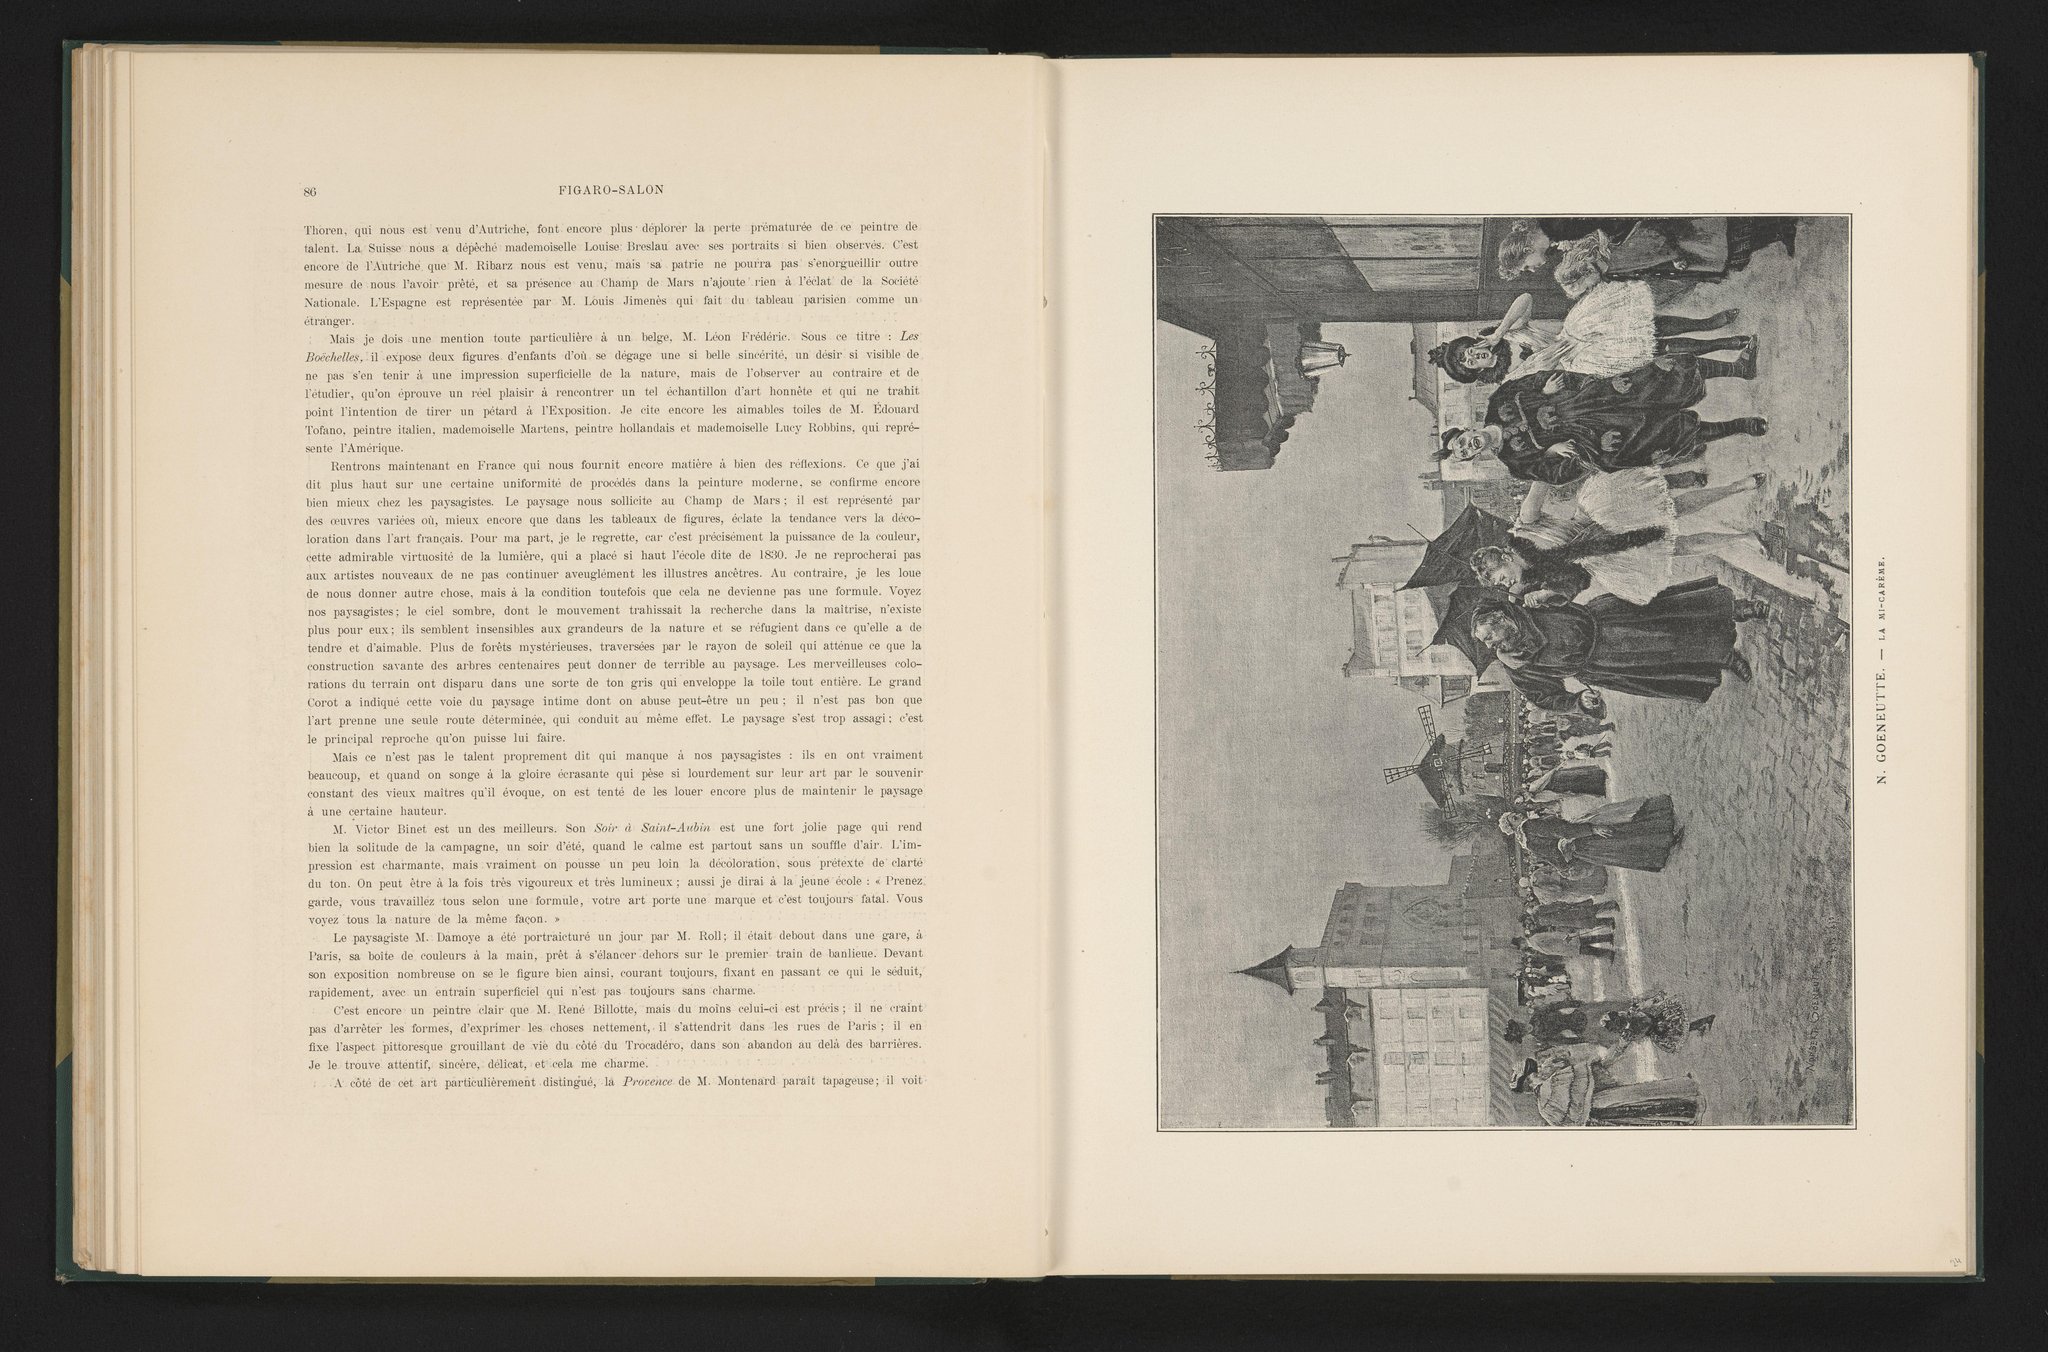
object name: reproduction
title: La mi-carème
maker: Anonymous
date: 1885-1901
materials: paper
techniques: autotype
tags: square, place, circus, etc., public festivities